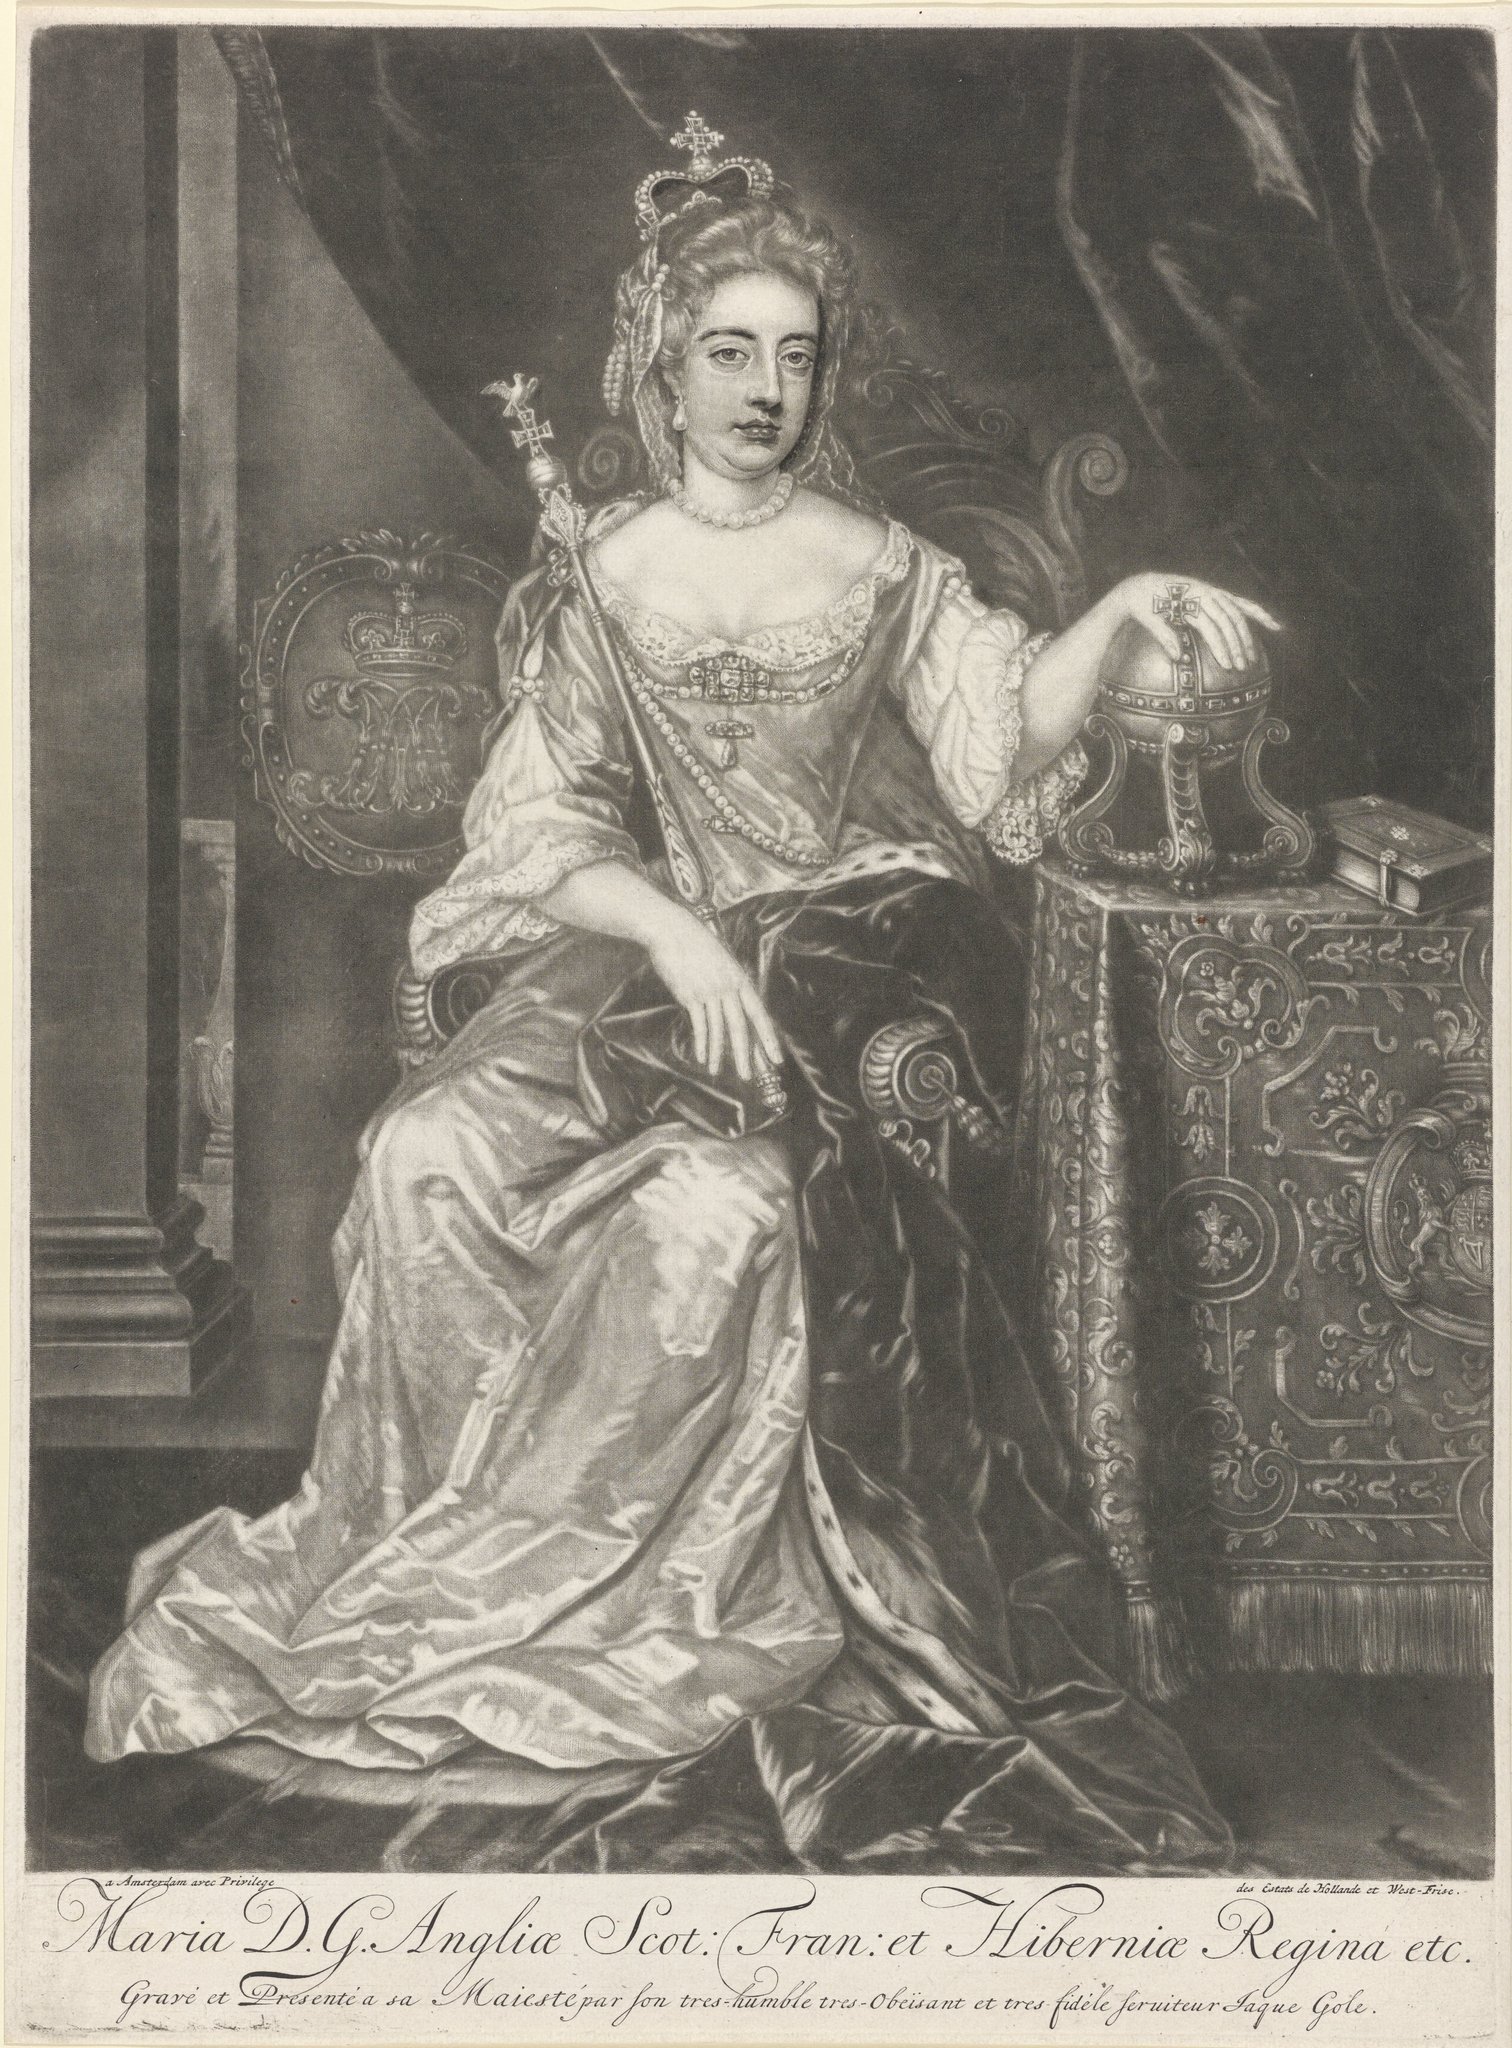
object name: print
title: Portret van Maria II Stuart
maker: jacob gole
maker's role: print maker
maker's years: 1660-1724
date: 1688-1724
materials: paper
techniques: mezzotint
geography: amsterdam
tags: london, maria ii stuart (koningin van engeland, schotland en ierland)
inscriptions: collector's mark: Lugt 963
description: Portret van Maria II met een kroon. In haar rechterhand een scepter. Haar linkerhand op de rijkspappel. In de ondermarge haar naam en titels.